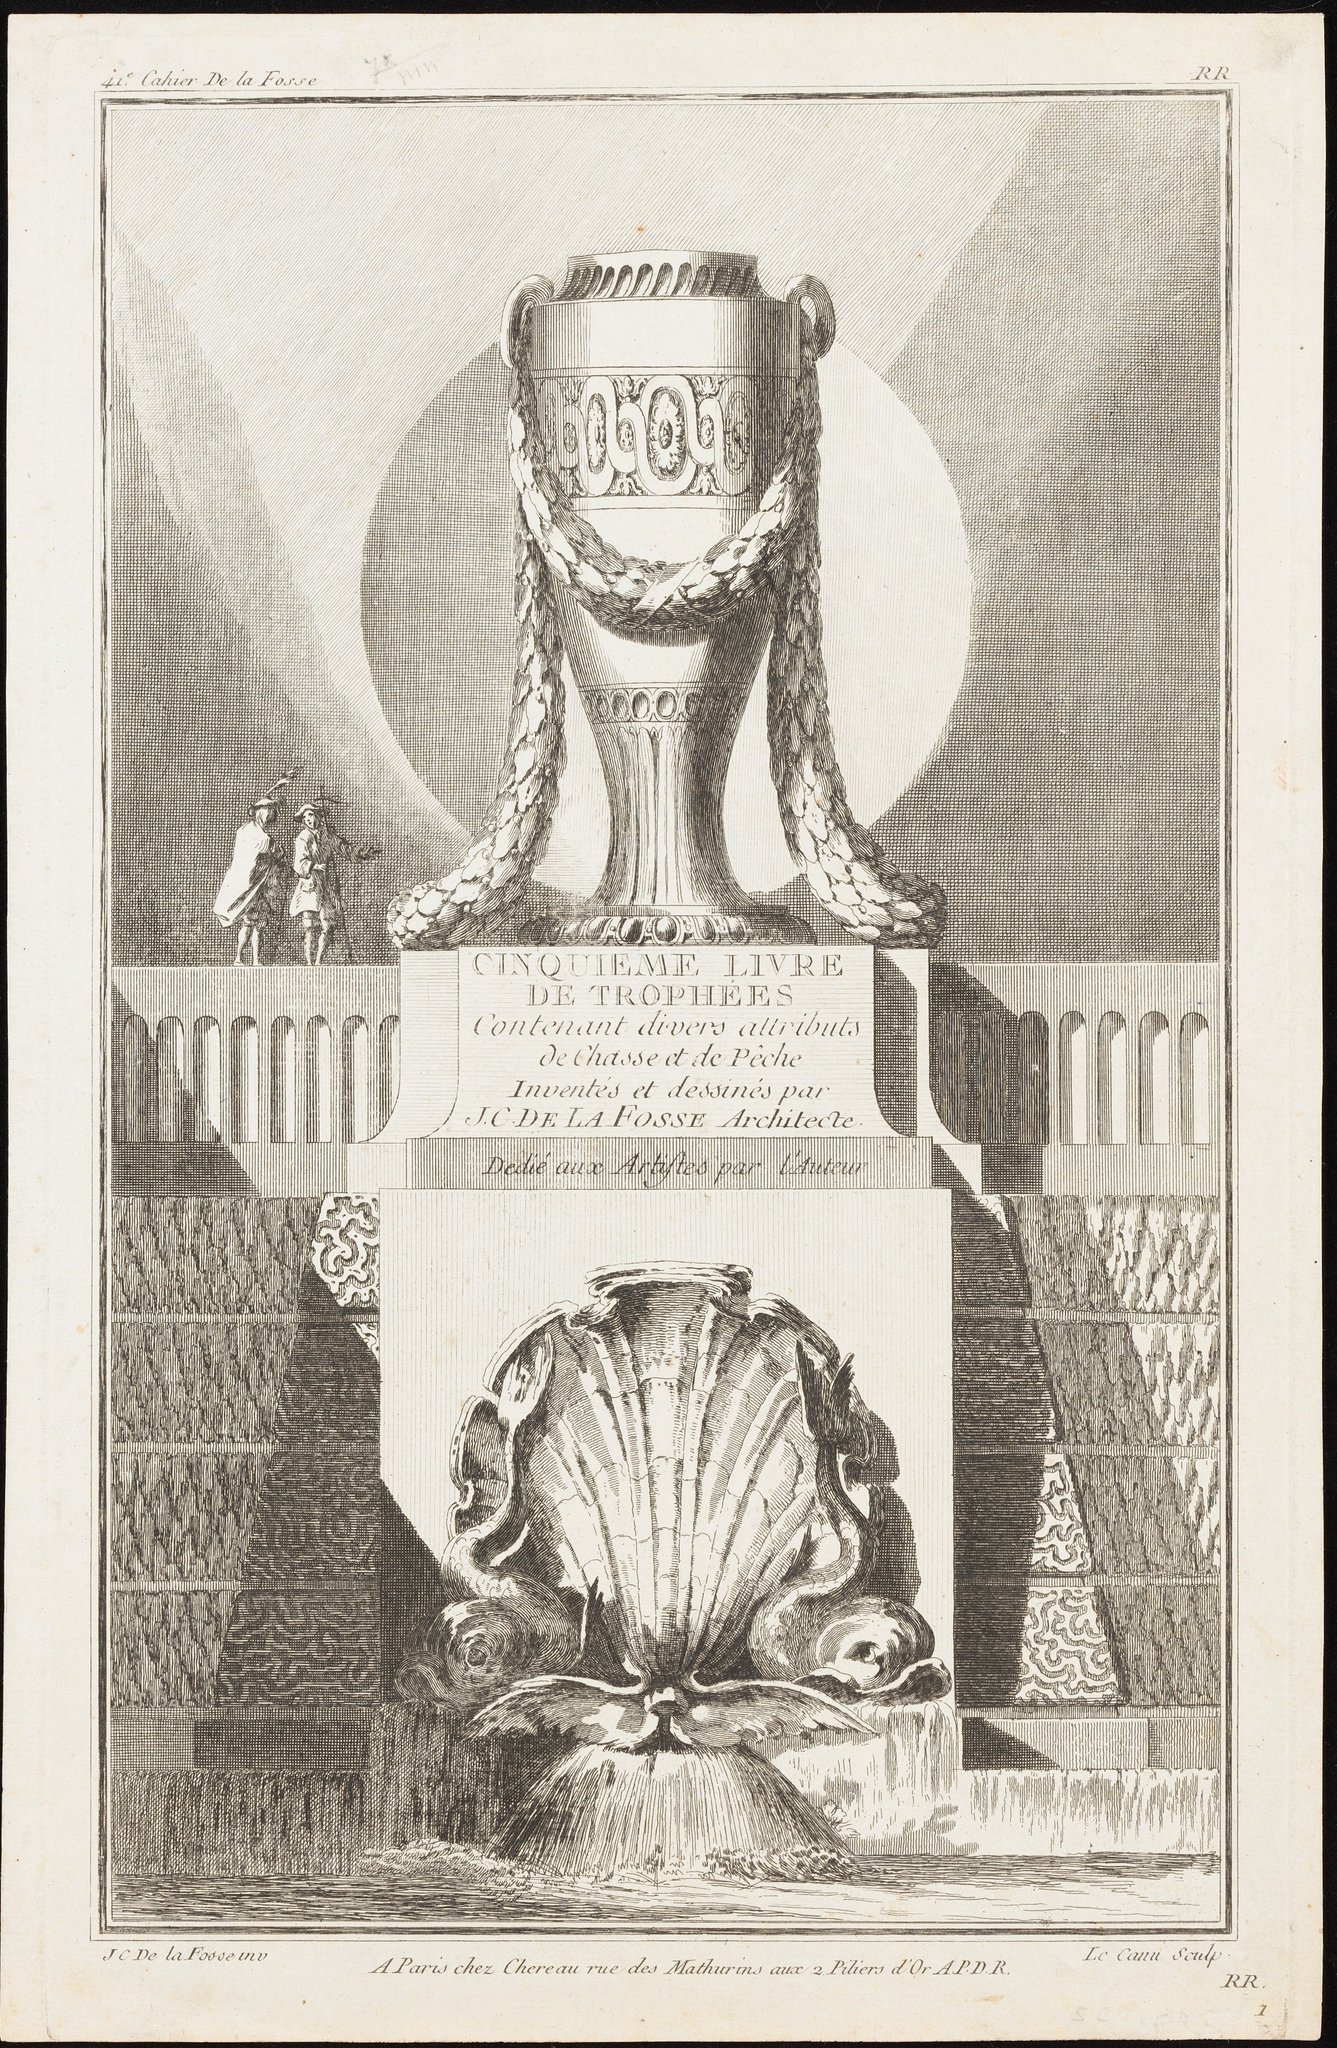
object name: print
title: Title page from Cinquieme Livre de Trophées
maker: jean charles delafosse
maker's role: artist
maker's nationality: french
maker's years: 1734-1789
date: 1701-1800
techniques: etching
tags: human figures,trophies